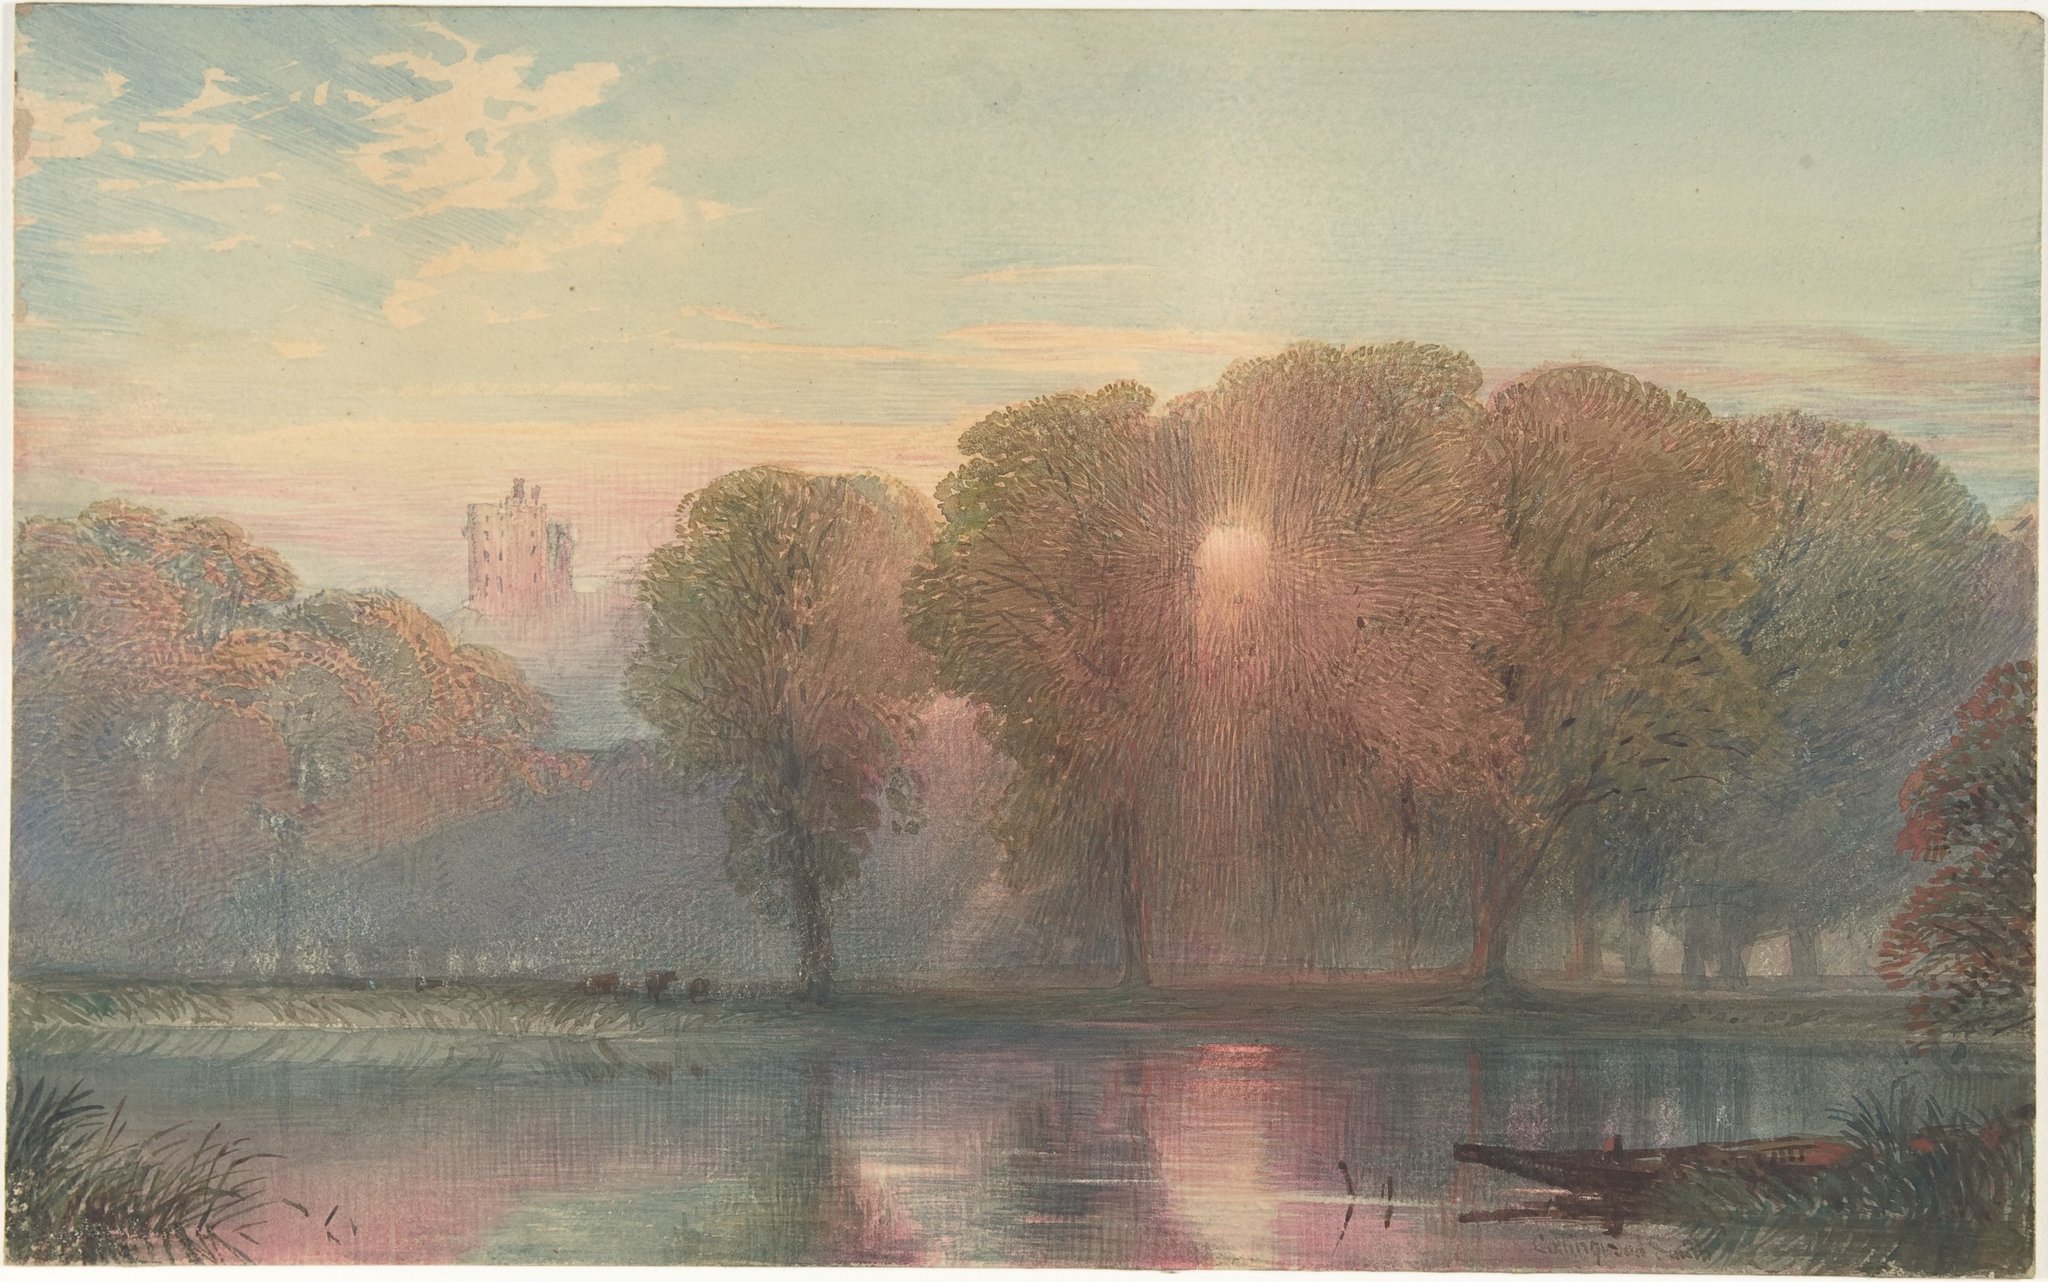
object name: drawing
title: Windsor from Datchet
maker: william collingwood smith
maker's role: artist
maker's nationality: british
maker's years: 1815-1887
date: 1870-1878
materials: watercolor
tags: landscapes,trees,boats